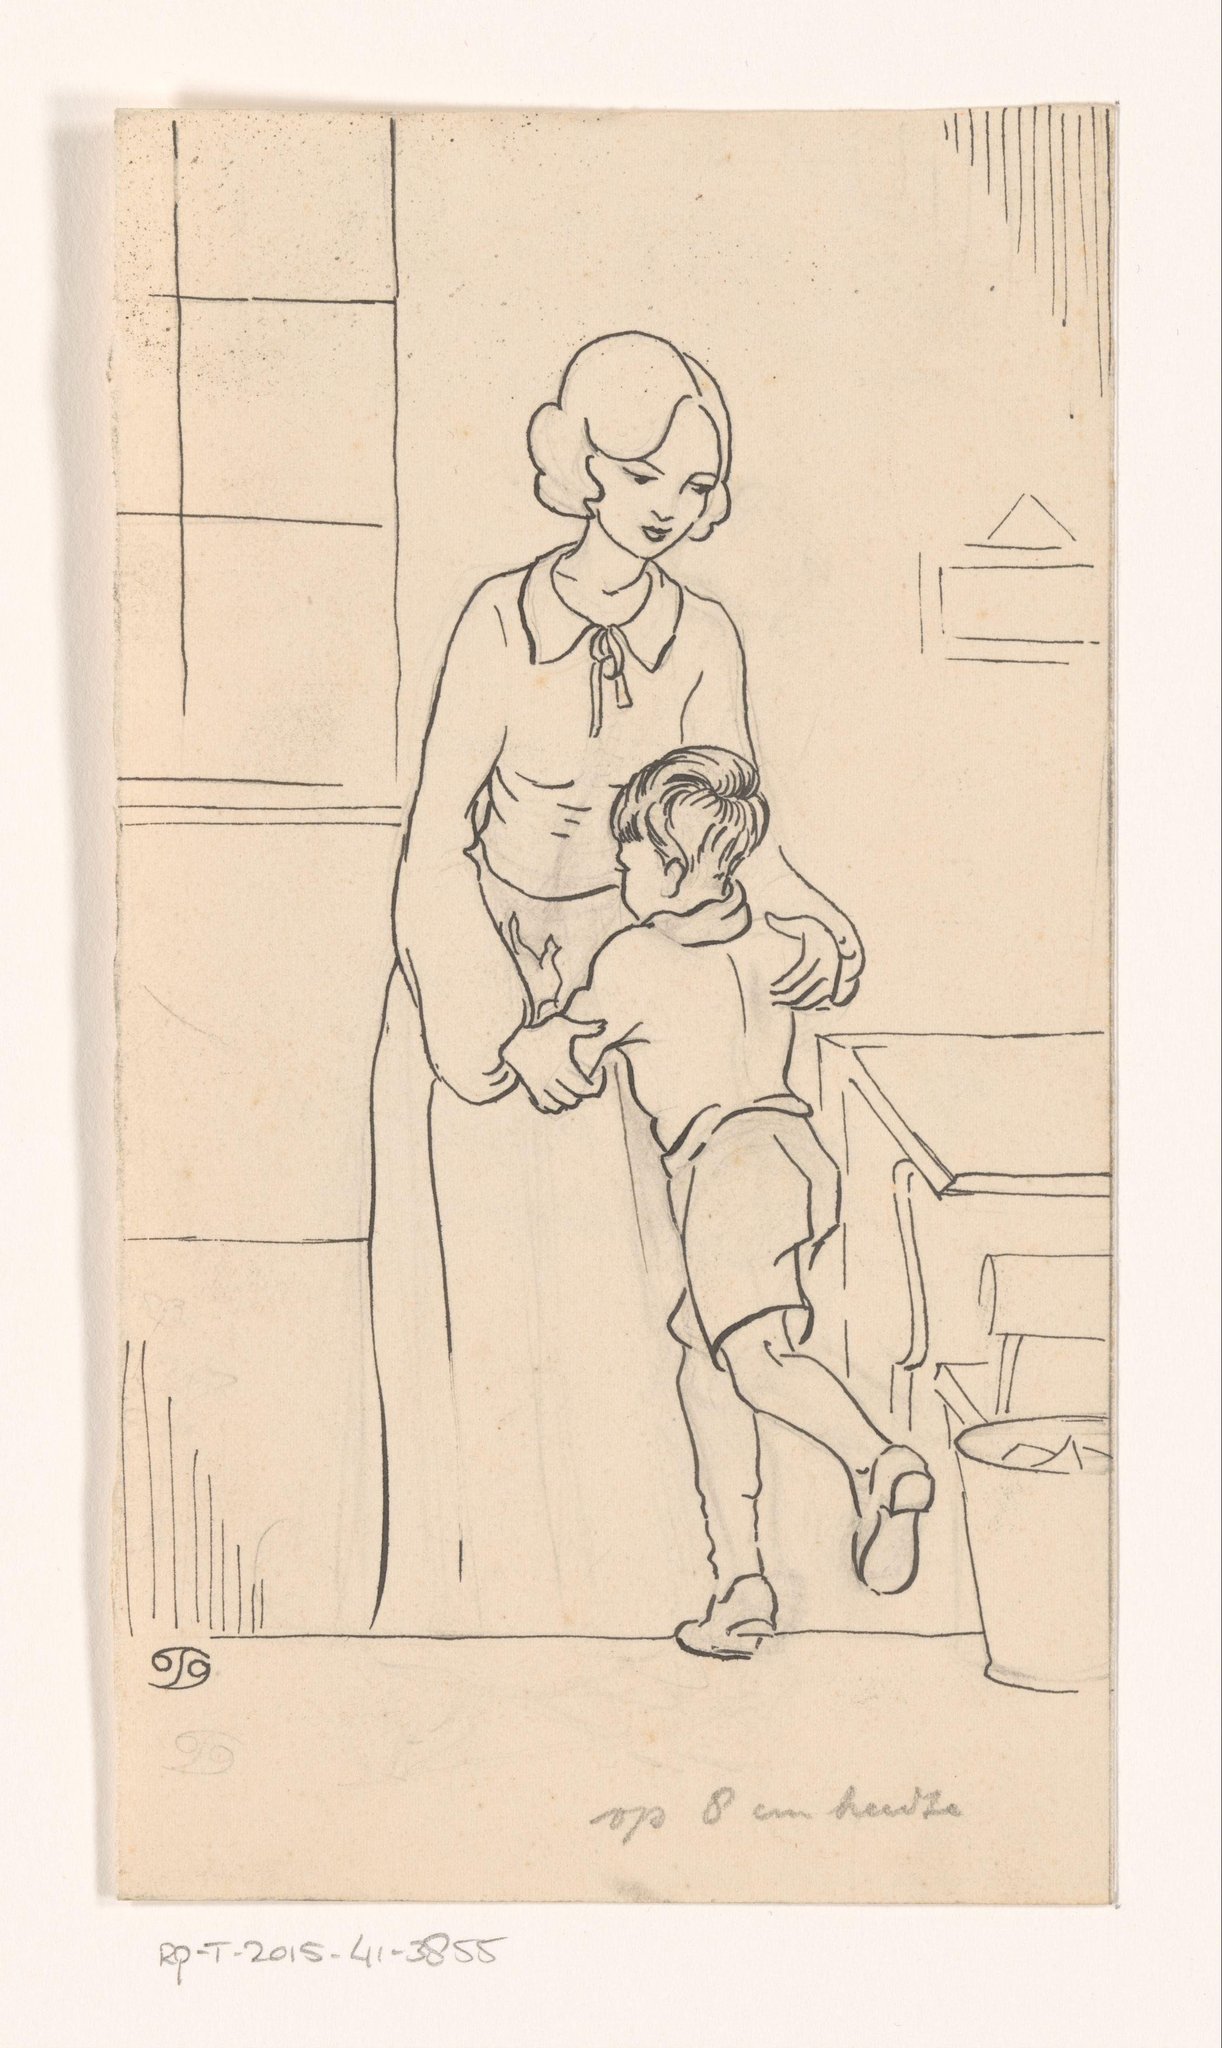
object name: drawing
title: Jongen knuffelt zijn moeder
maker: Anonymous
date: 1890-1940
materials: ink, paper, pencil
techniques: pen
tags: embracing each other, kissing, mother and baby or young child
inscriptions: annotation: ‘Koude voetjes’, monogram